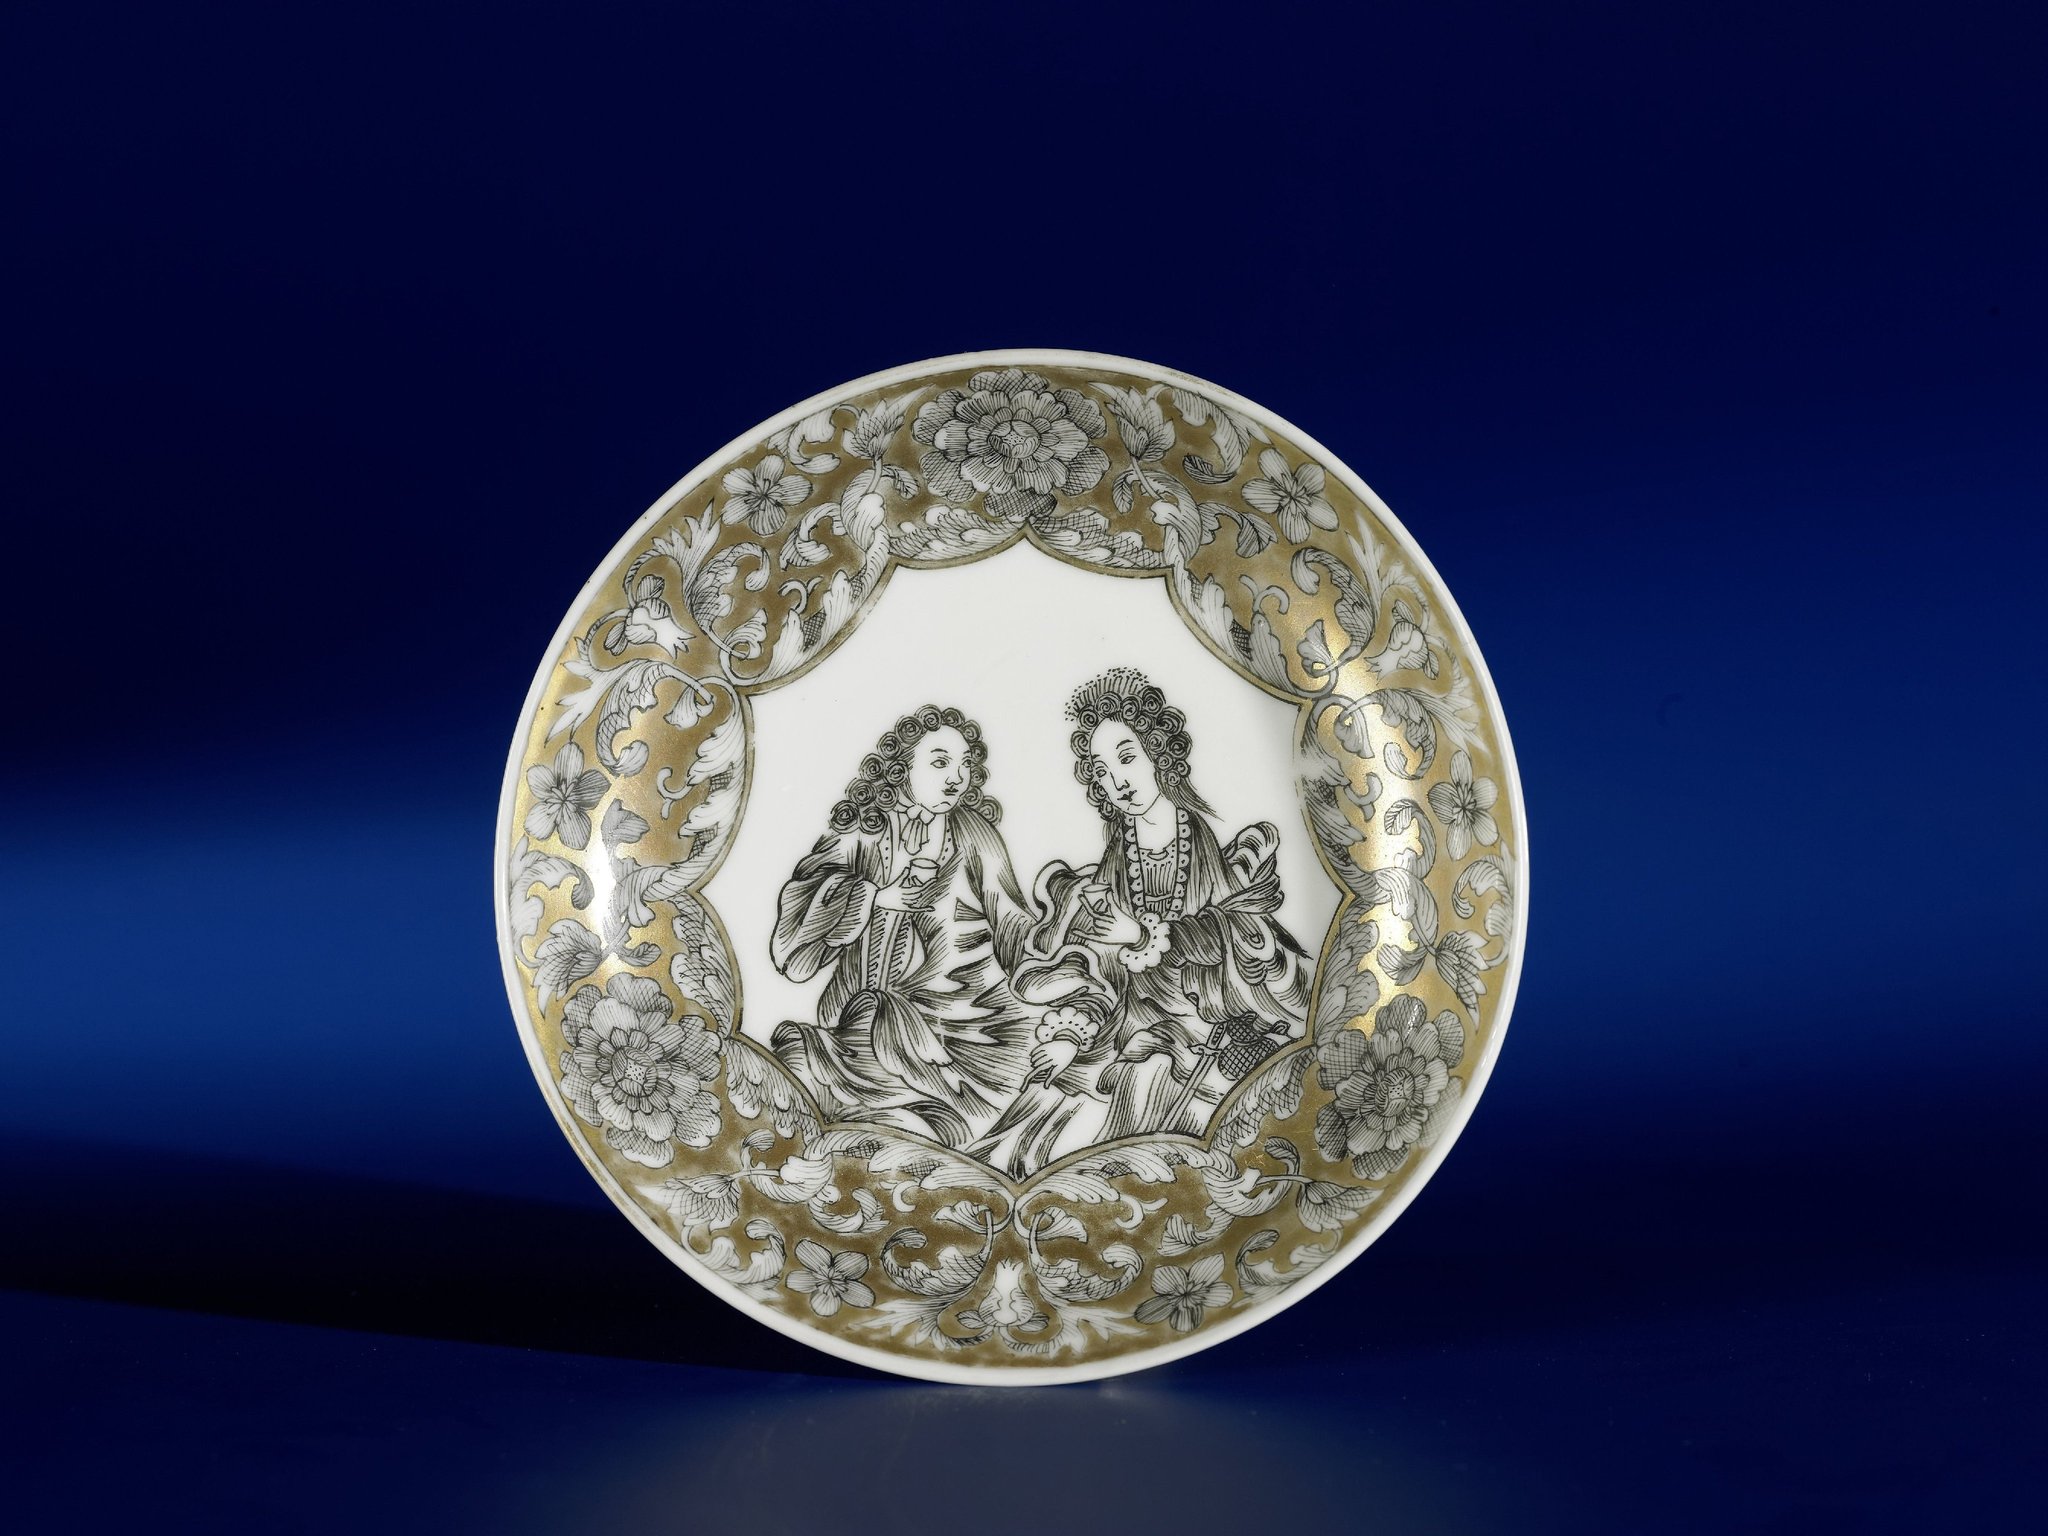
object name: platter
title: Saucer with a European, possibly tea drinking, couple in a scalloped panel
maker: Anonymous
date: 1725-1749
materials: glaze, gold, paint, porcelain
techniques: firing, gilding, turning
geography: china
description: Schotel van porselein, beschilderd op het glazuur in zwart en goud. Op het plat een Europees paar met elk een kopje in de hand in een geschulpt cartouche; op de wand zijn bloemranken uitgespaard in een gouden grond. Europese voorstelling in encre de Chine.